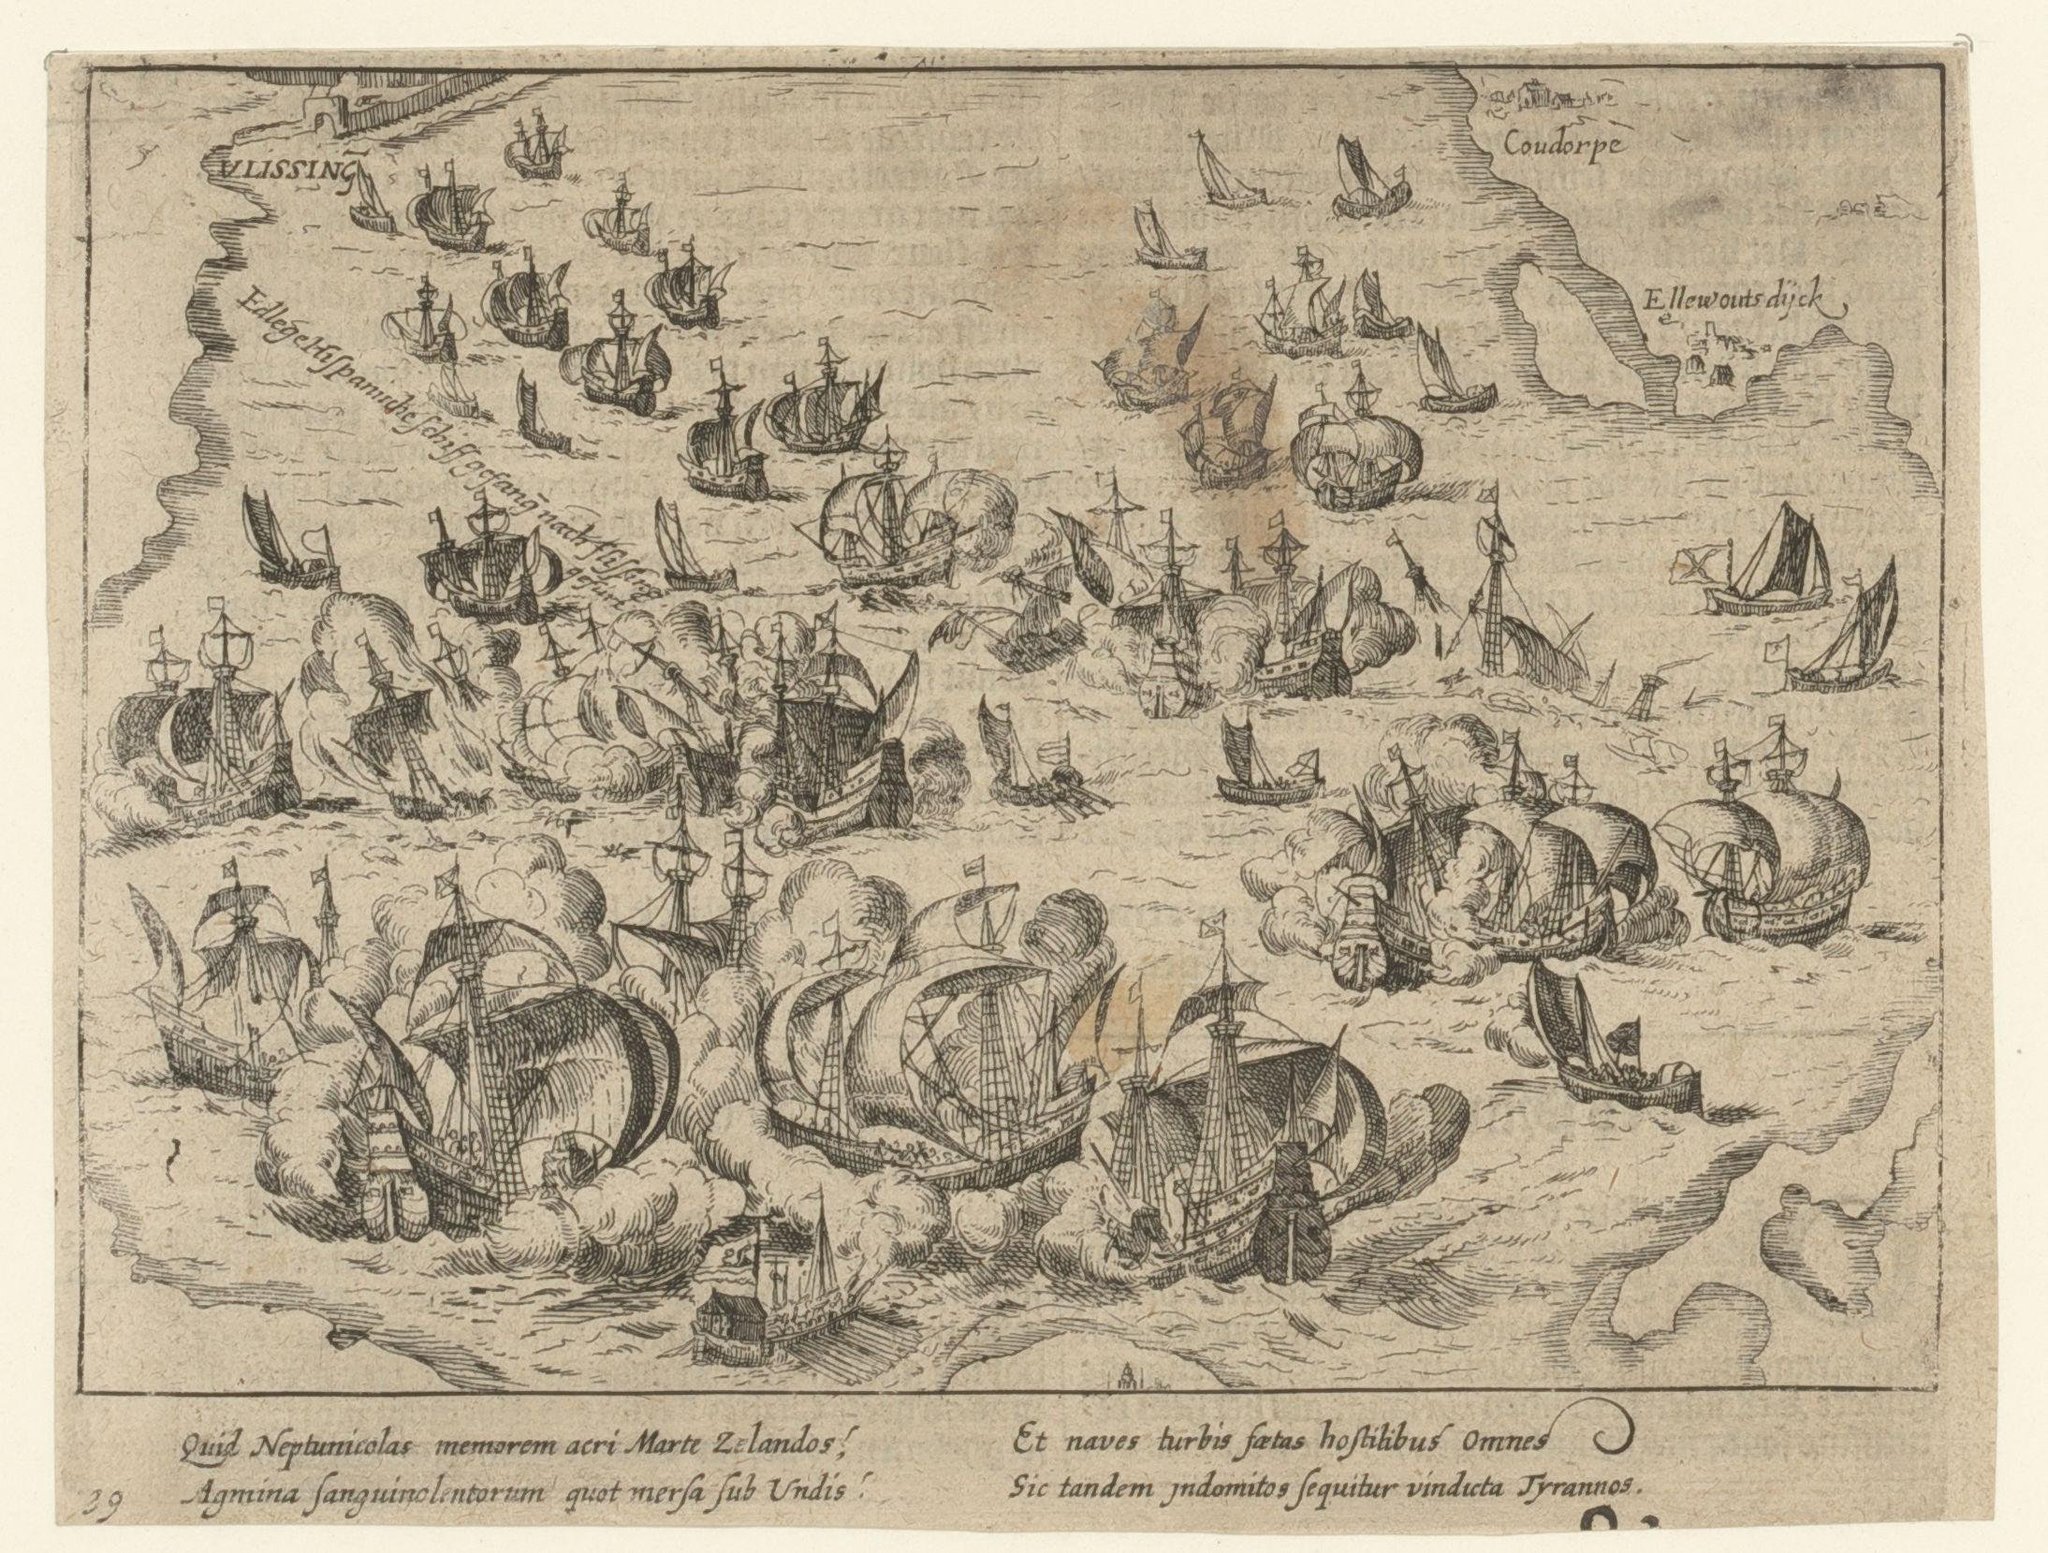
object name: history print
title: Overwinning op de Spaanse vloot bij Vlissingen, 1573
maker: Anonymous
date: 1613-1615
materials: paper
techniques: etching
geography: northern netherlands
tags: battle (+ naval force), flushing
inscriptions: collector's mark: Lugt 1641, collector's mark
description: Overwinning op de Spaanse vloot bij Vlissingen, 22 -23 april 1573. De Spaanse schepen die Middelburg wilden ontzetten worden door de watergeuzen verslagen op de Schelde bij Vlissingen. Met onderschrift van 4 regels in het Latijn. Genummerd: 39. Bedrukt op achterzijde met tekst in het Nederlands. Onderwerpsrubrieken binnen de Atlas Zeden en Gewoonten: Krijgswezen; prenten van Baudart. 80j. oorlog.